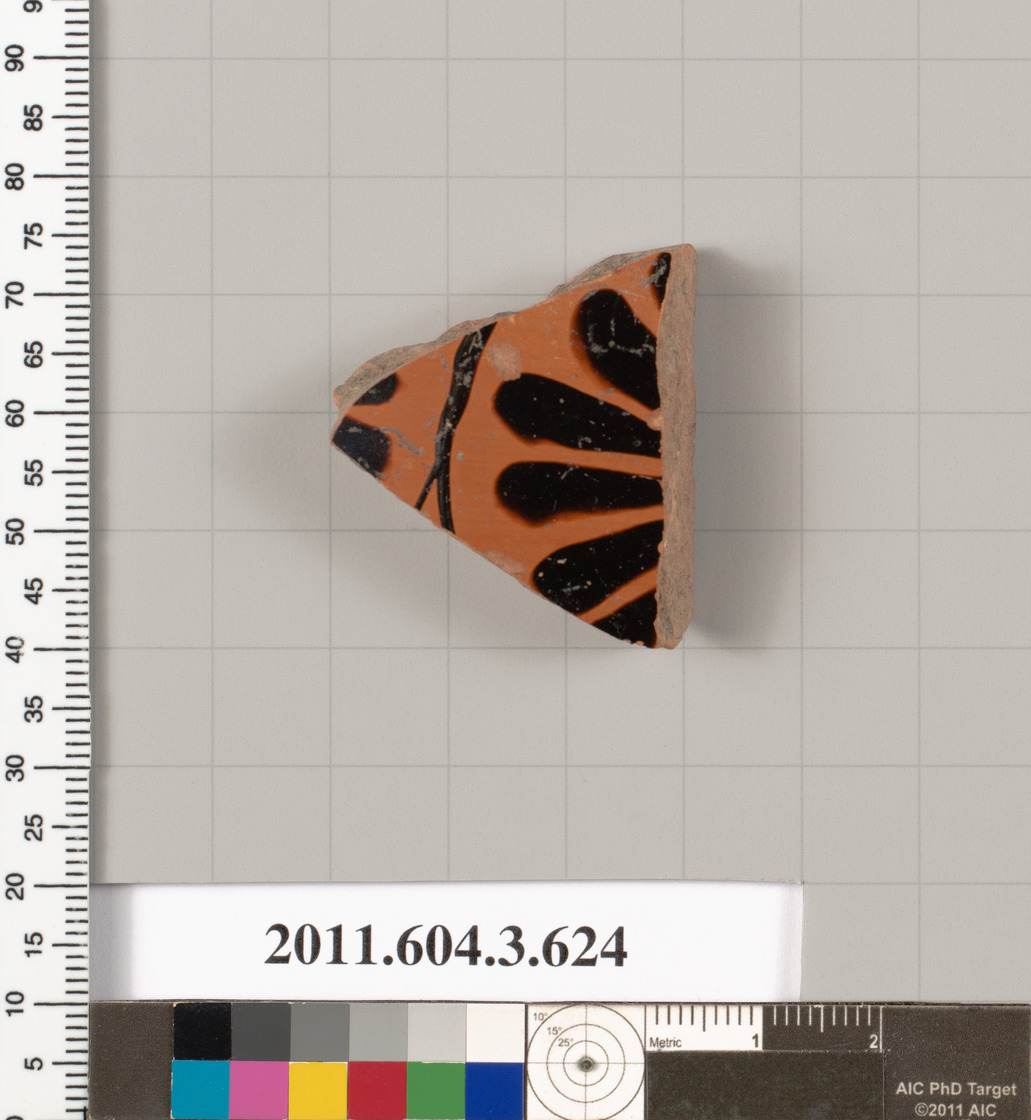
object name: calyx krater fragment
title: Terracotta fragment of a calyx-krater (bowl for mixing wine and water)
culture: greek, attic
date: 500-480 BCE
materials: terracotta